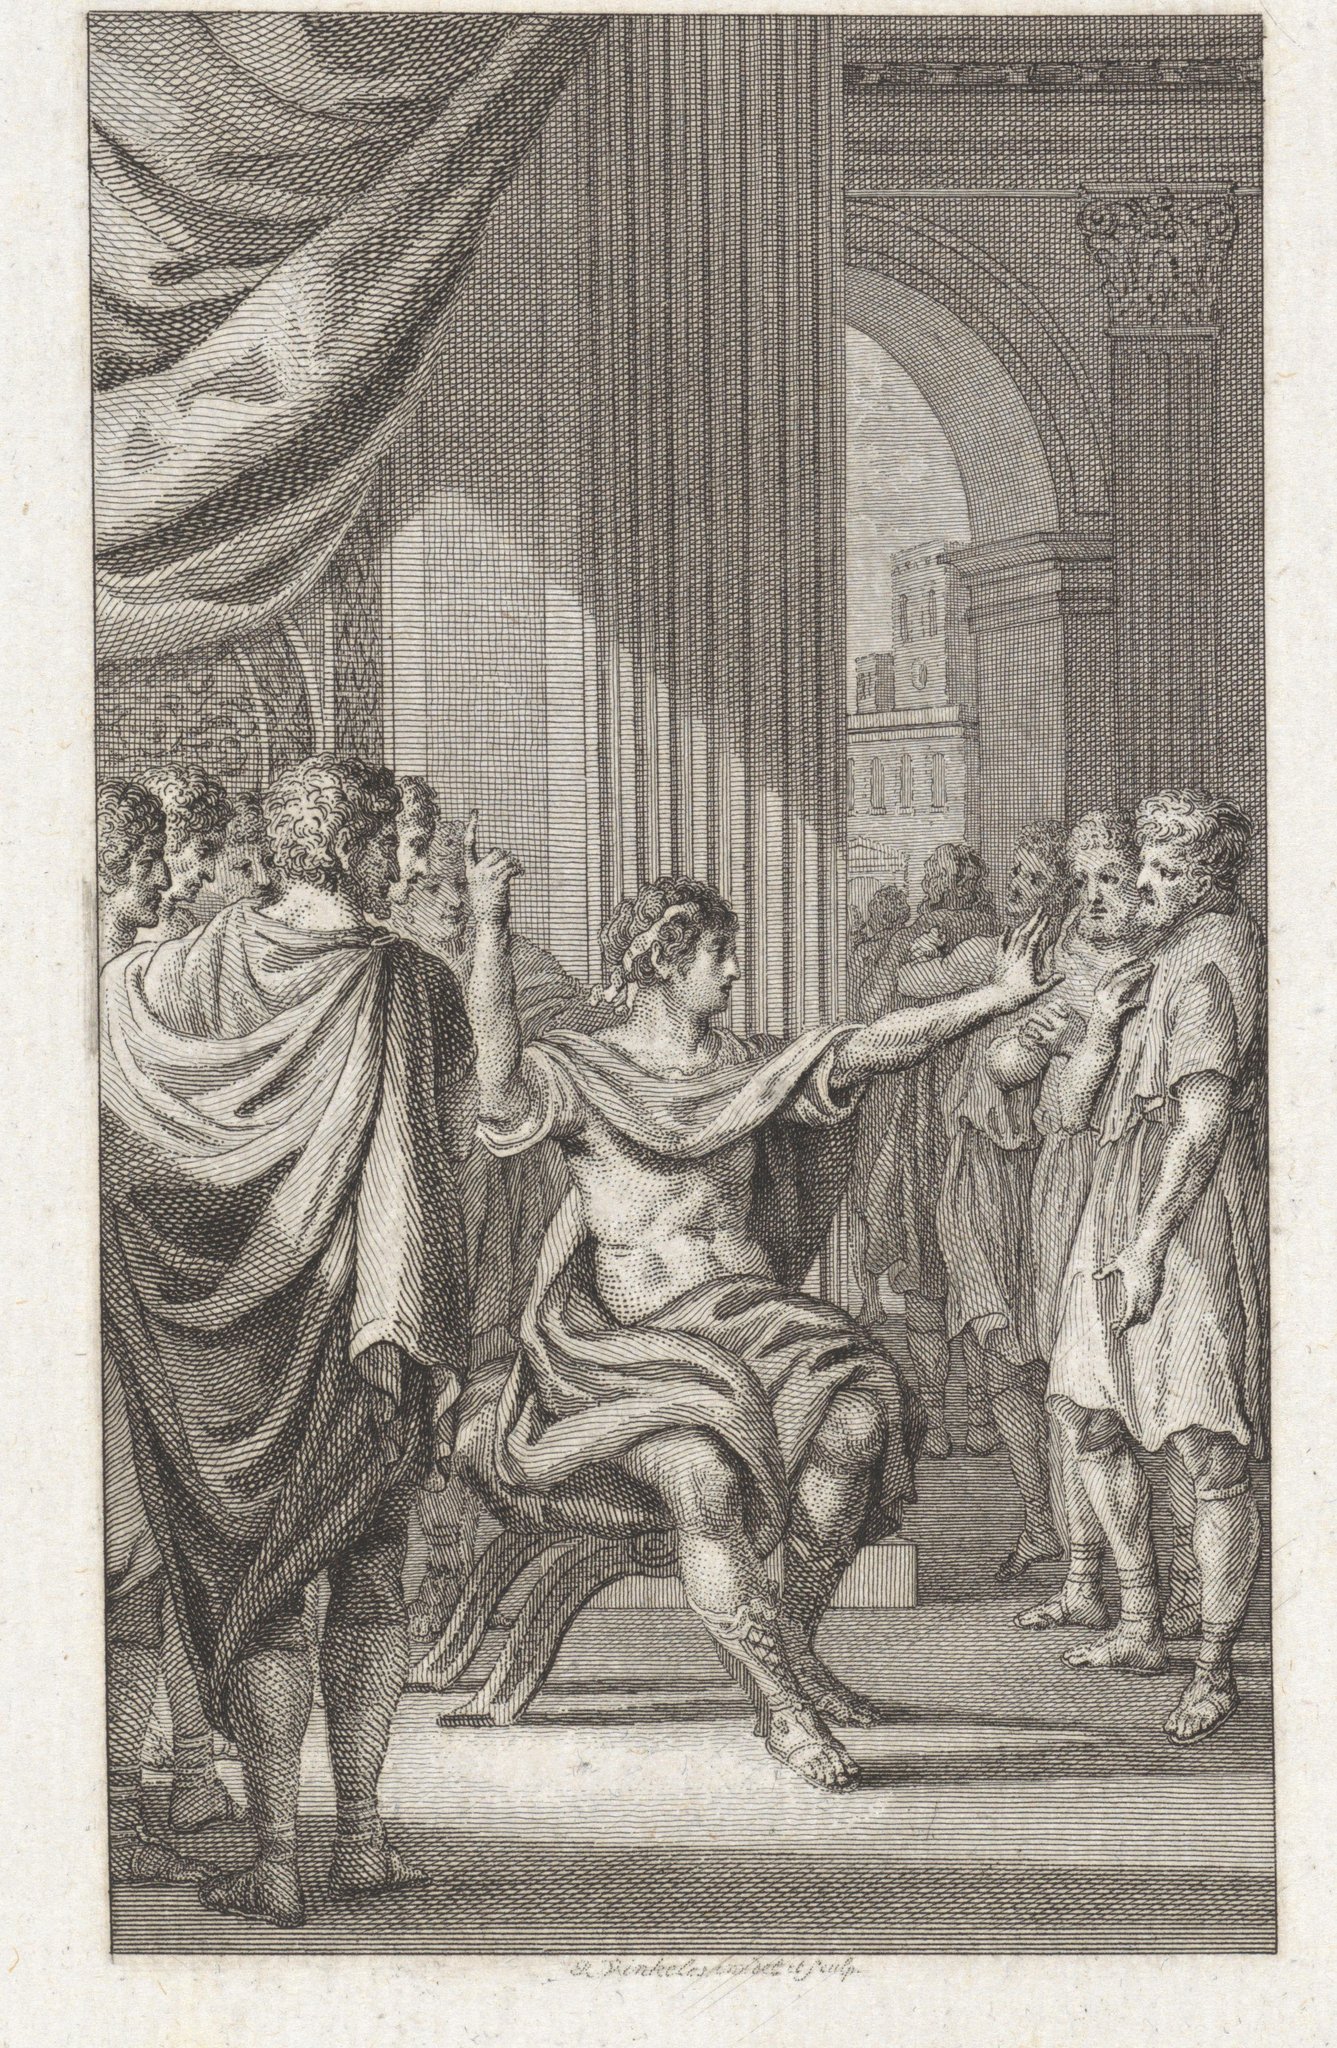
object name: print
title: Keizer Augustus spreekt tot de hovelingen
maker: reinier vinkeles (i)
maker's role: draughtsman, print maker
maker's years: 1741-1816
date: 1800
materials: paper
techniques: engraving, etching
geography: amsterdam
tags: speaking, ruler, sovereign, index finger forwards, pointing, indicating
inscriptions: collector's mark: Lugt 240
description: Proefdruk van illustratie in: Hamelsveld, Ysbrand van. Algemeene kerkelijke geschiedenis, der Christenen, deel 3. Haarlem: François Bohn, 1800, p. 343.